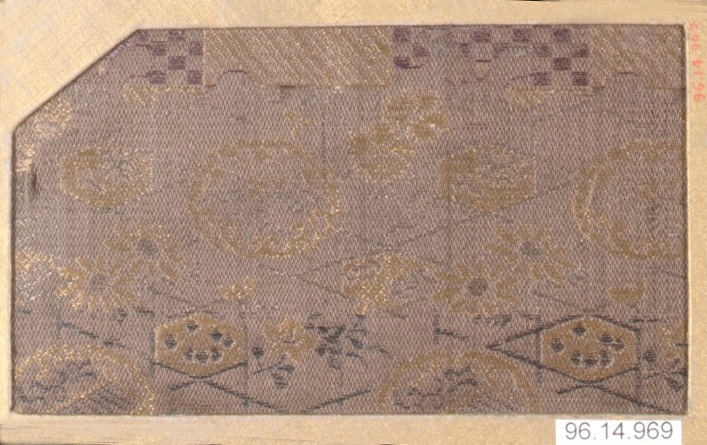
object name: piece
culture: japanese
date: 1701-1900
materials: silk